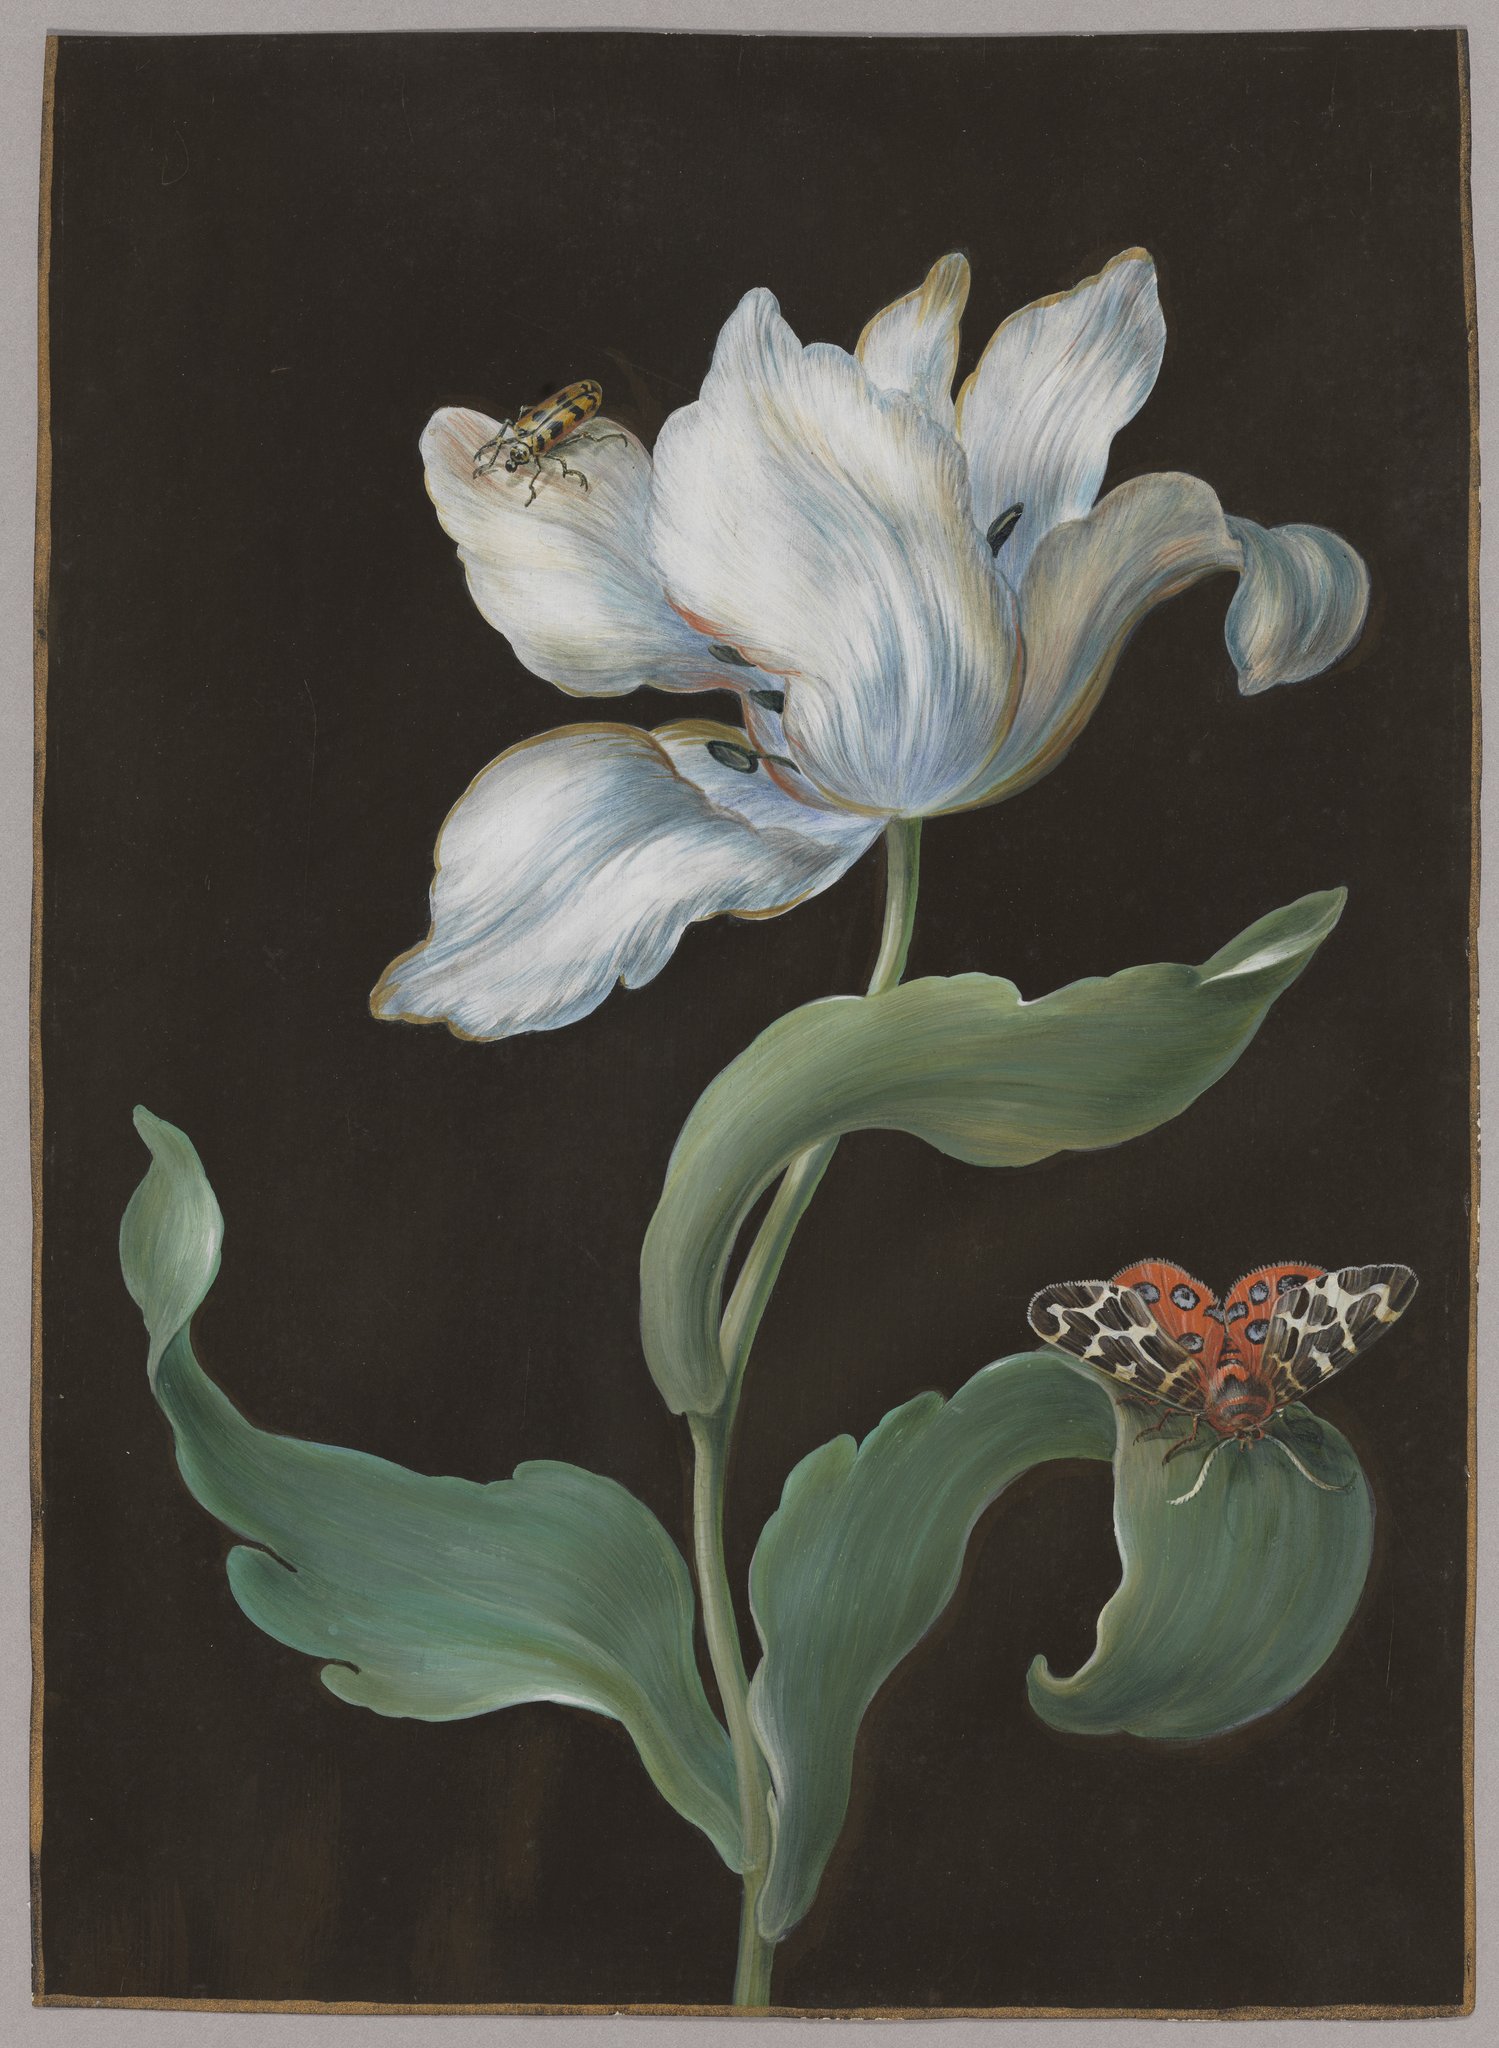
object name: drawing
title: A tulip, a butterfly of the species Arctia caja (garden tiger moth), and a beetle (possibly a longhorn)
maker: barbara regina dietzsch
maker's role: artist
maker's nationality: german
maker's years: 1706-1783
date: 1750-1760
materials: gold paint, parchment, watercolor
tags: butterflies,flowers,tulips